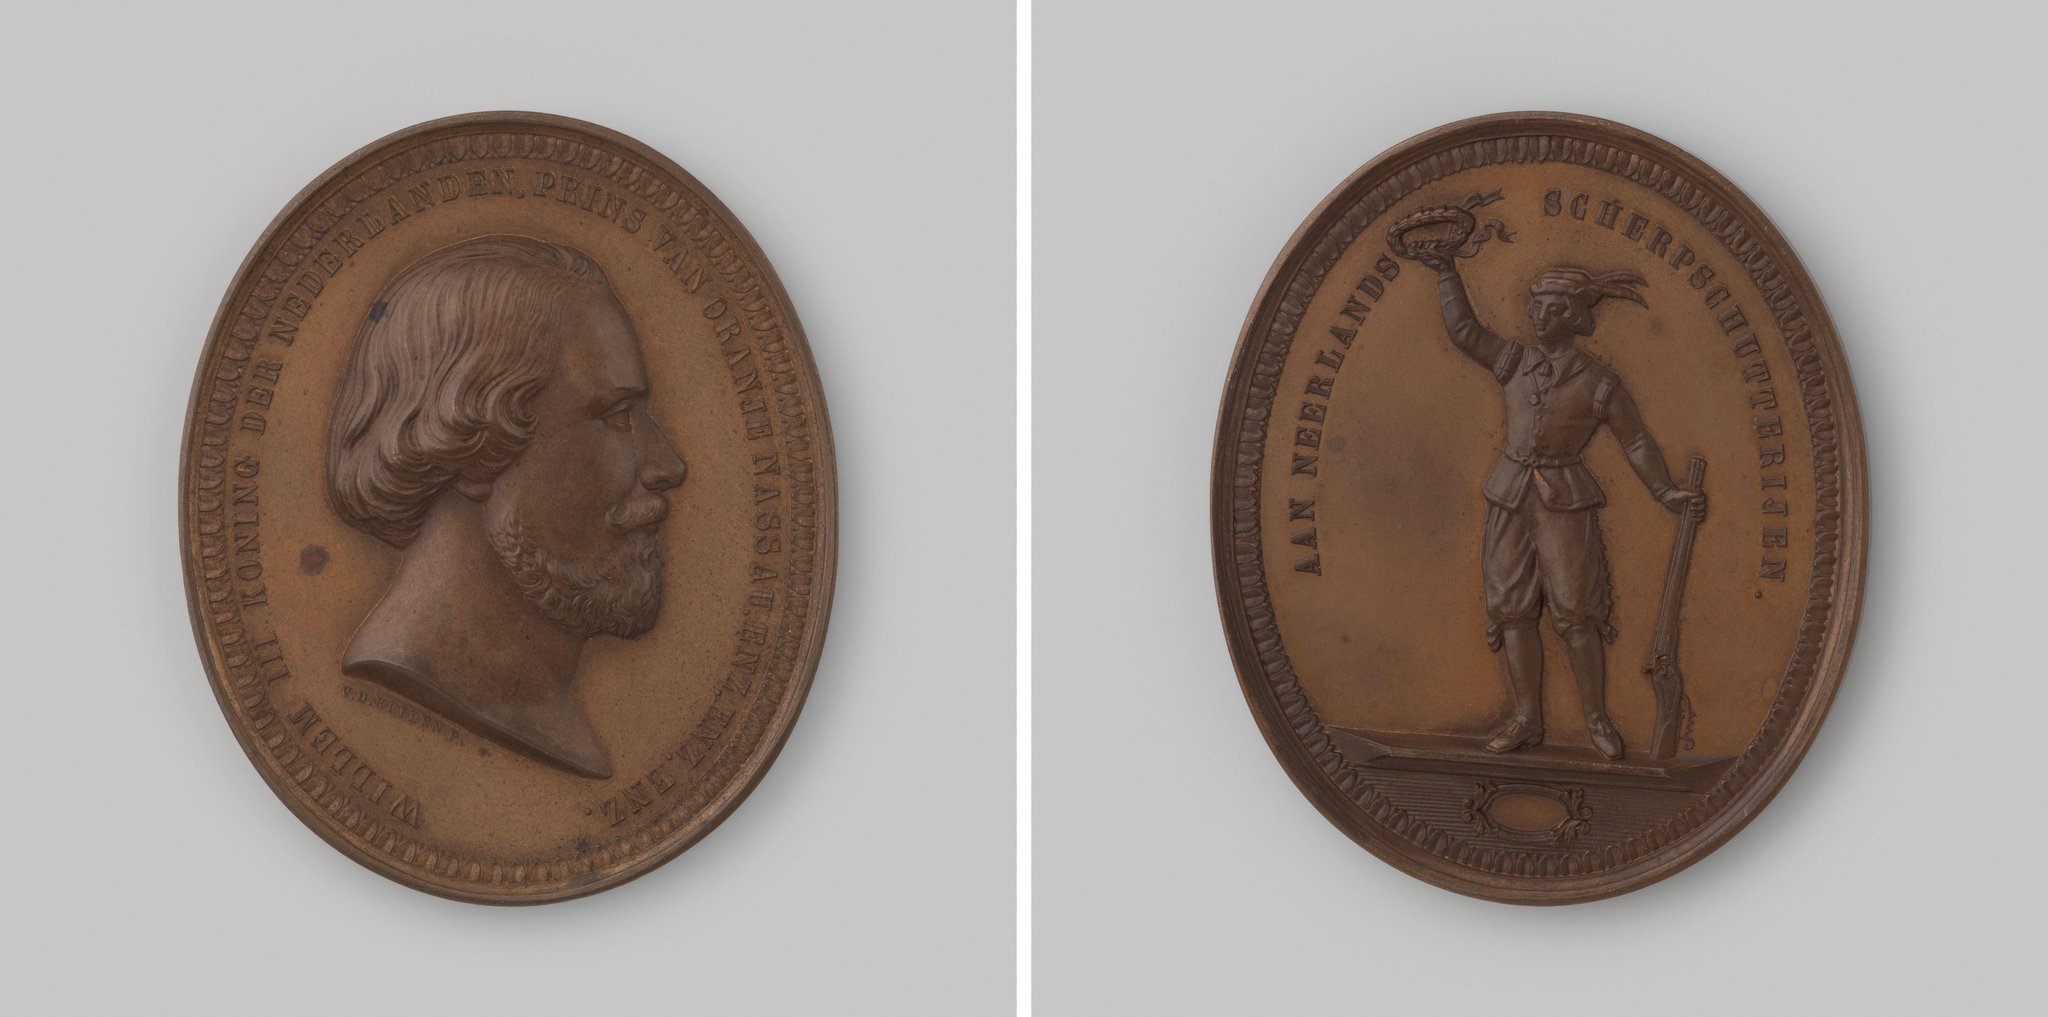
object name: history medal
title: Prijspenning van koning Willem III aan Neerlands Scherpschutterijen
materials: bronze